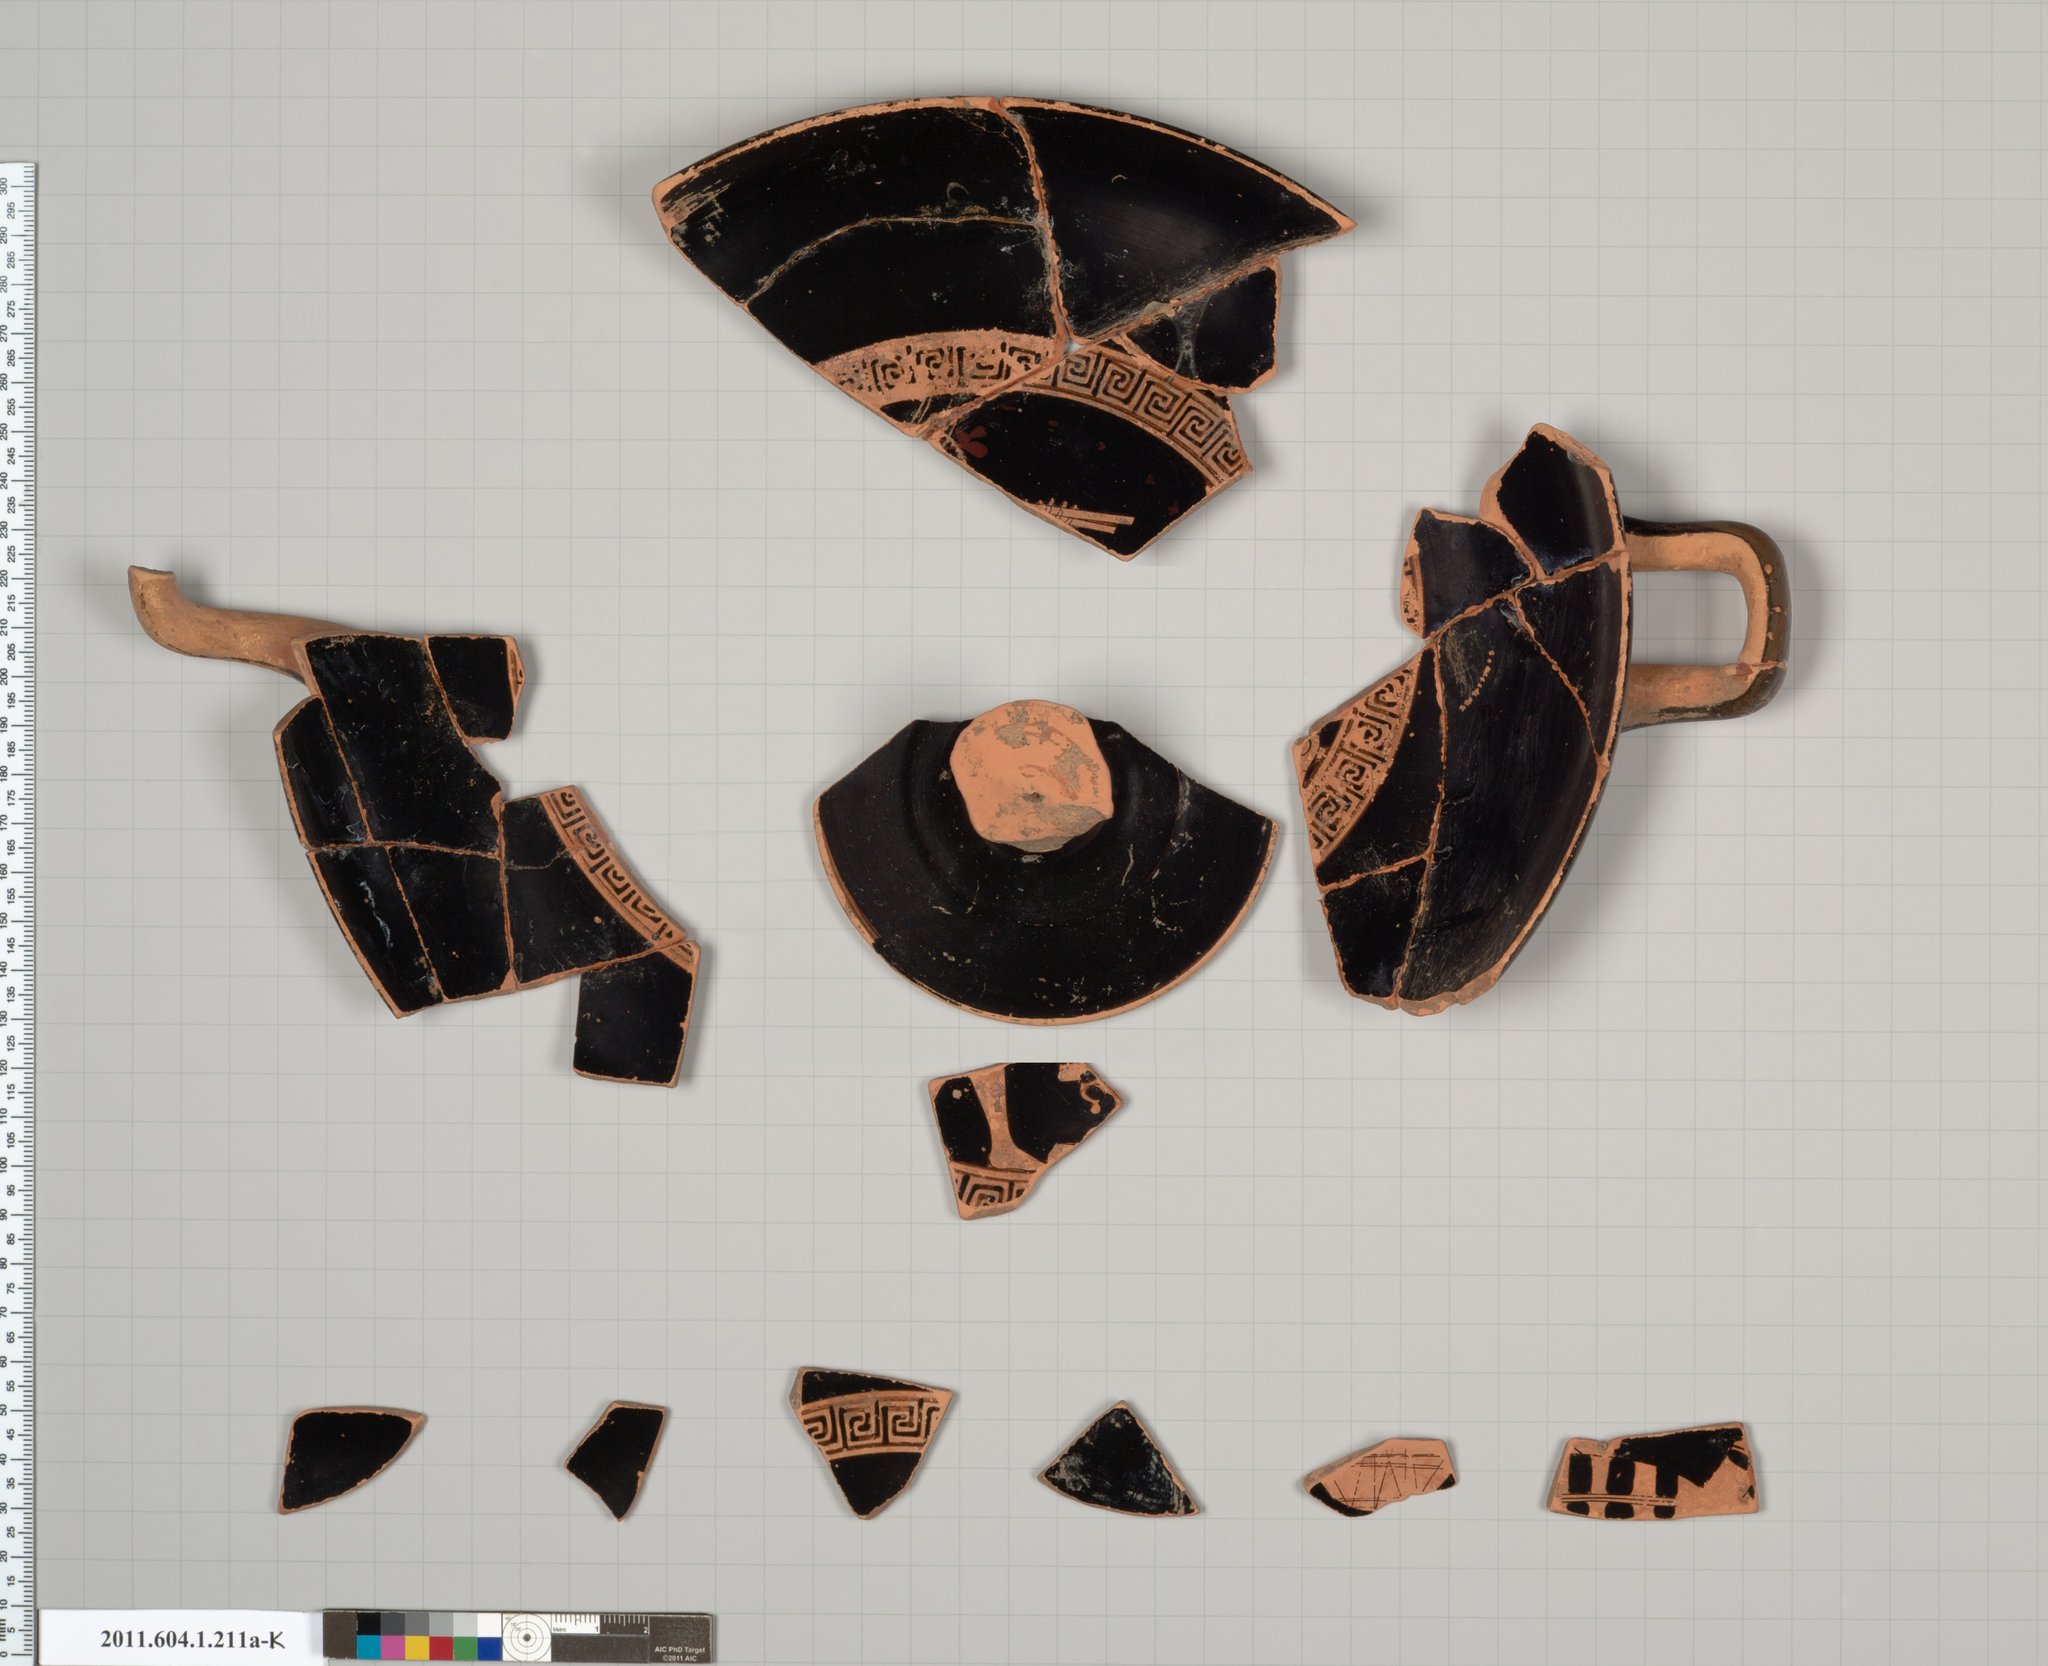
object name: kylix fragment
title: Terracotta fragments of a kylix (drinking cup)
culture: greek, attic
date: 475-451 BCE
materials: terracotta